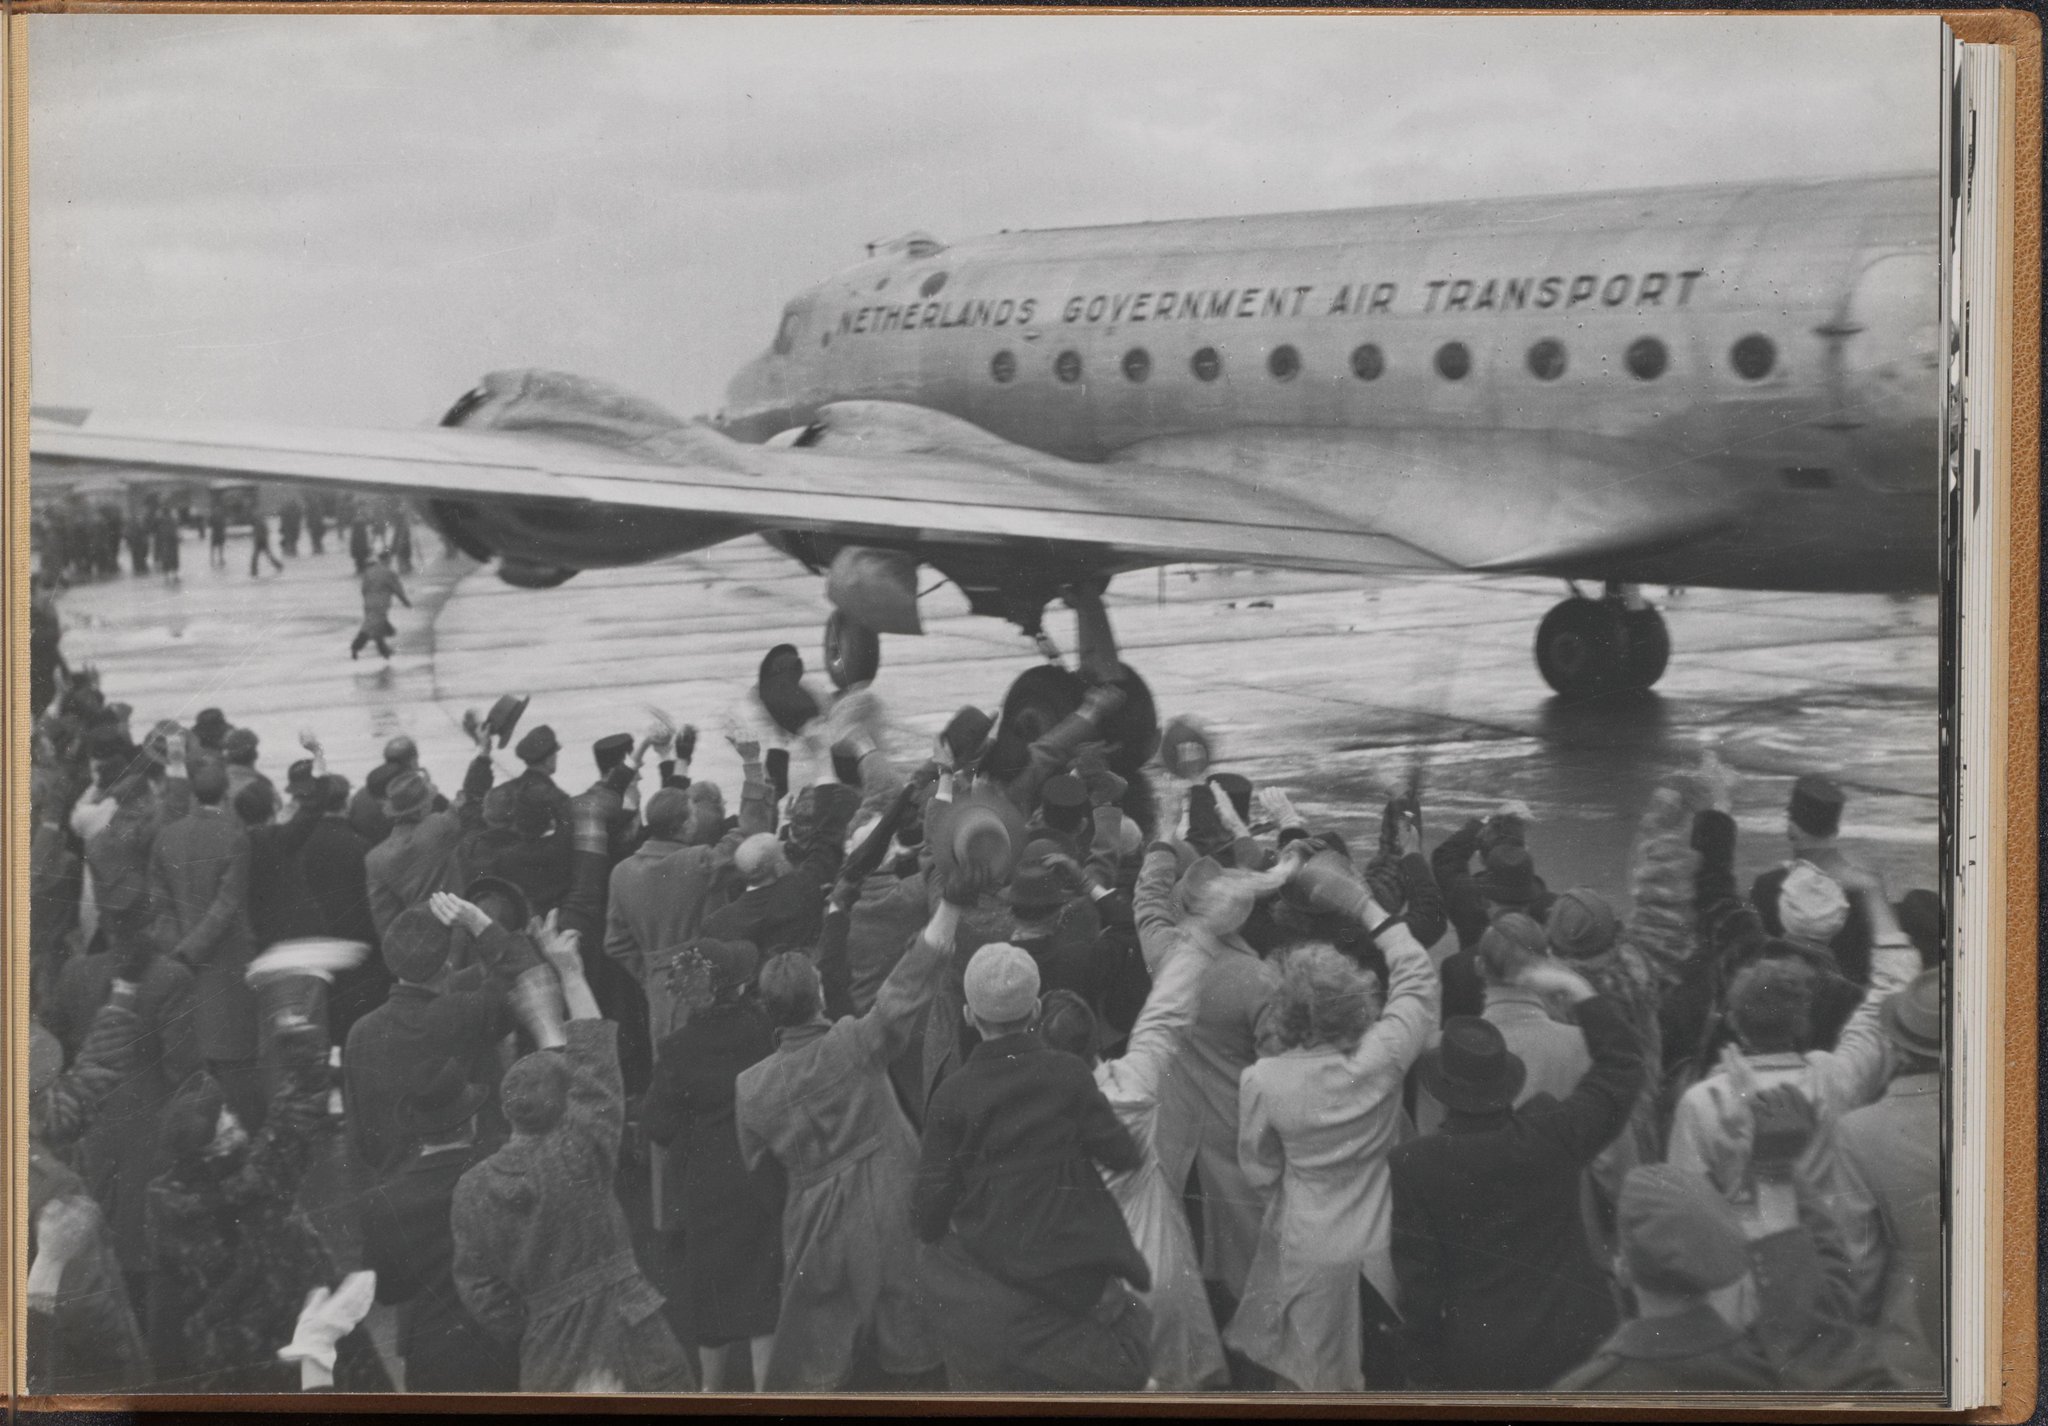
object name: album leaf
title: Begroeting van een vliegtuig van de Netherlands Government Air Transport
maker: Anonymous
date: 1945-1946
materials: cardboard, paper, photographic support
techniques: gelatin silver print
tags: aircraft, aeroplane, airborne traffic, aviation, airfield, airport, arrival and return ~ travelling, travelling; tourism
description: Albumblad met een foto van mensen die op een vliegveld een toestel van het Netherlands Government Air Transport begroeten (Nederlandse Regerings Luchttransportdienst). Onderdeel van Herdenkingsalbum van de Indië-lijn van de KLM, deel II.